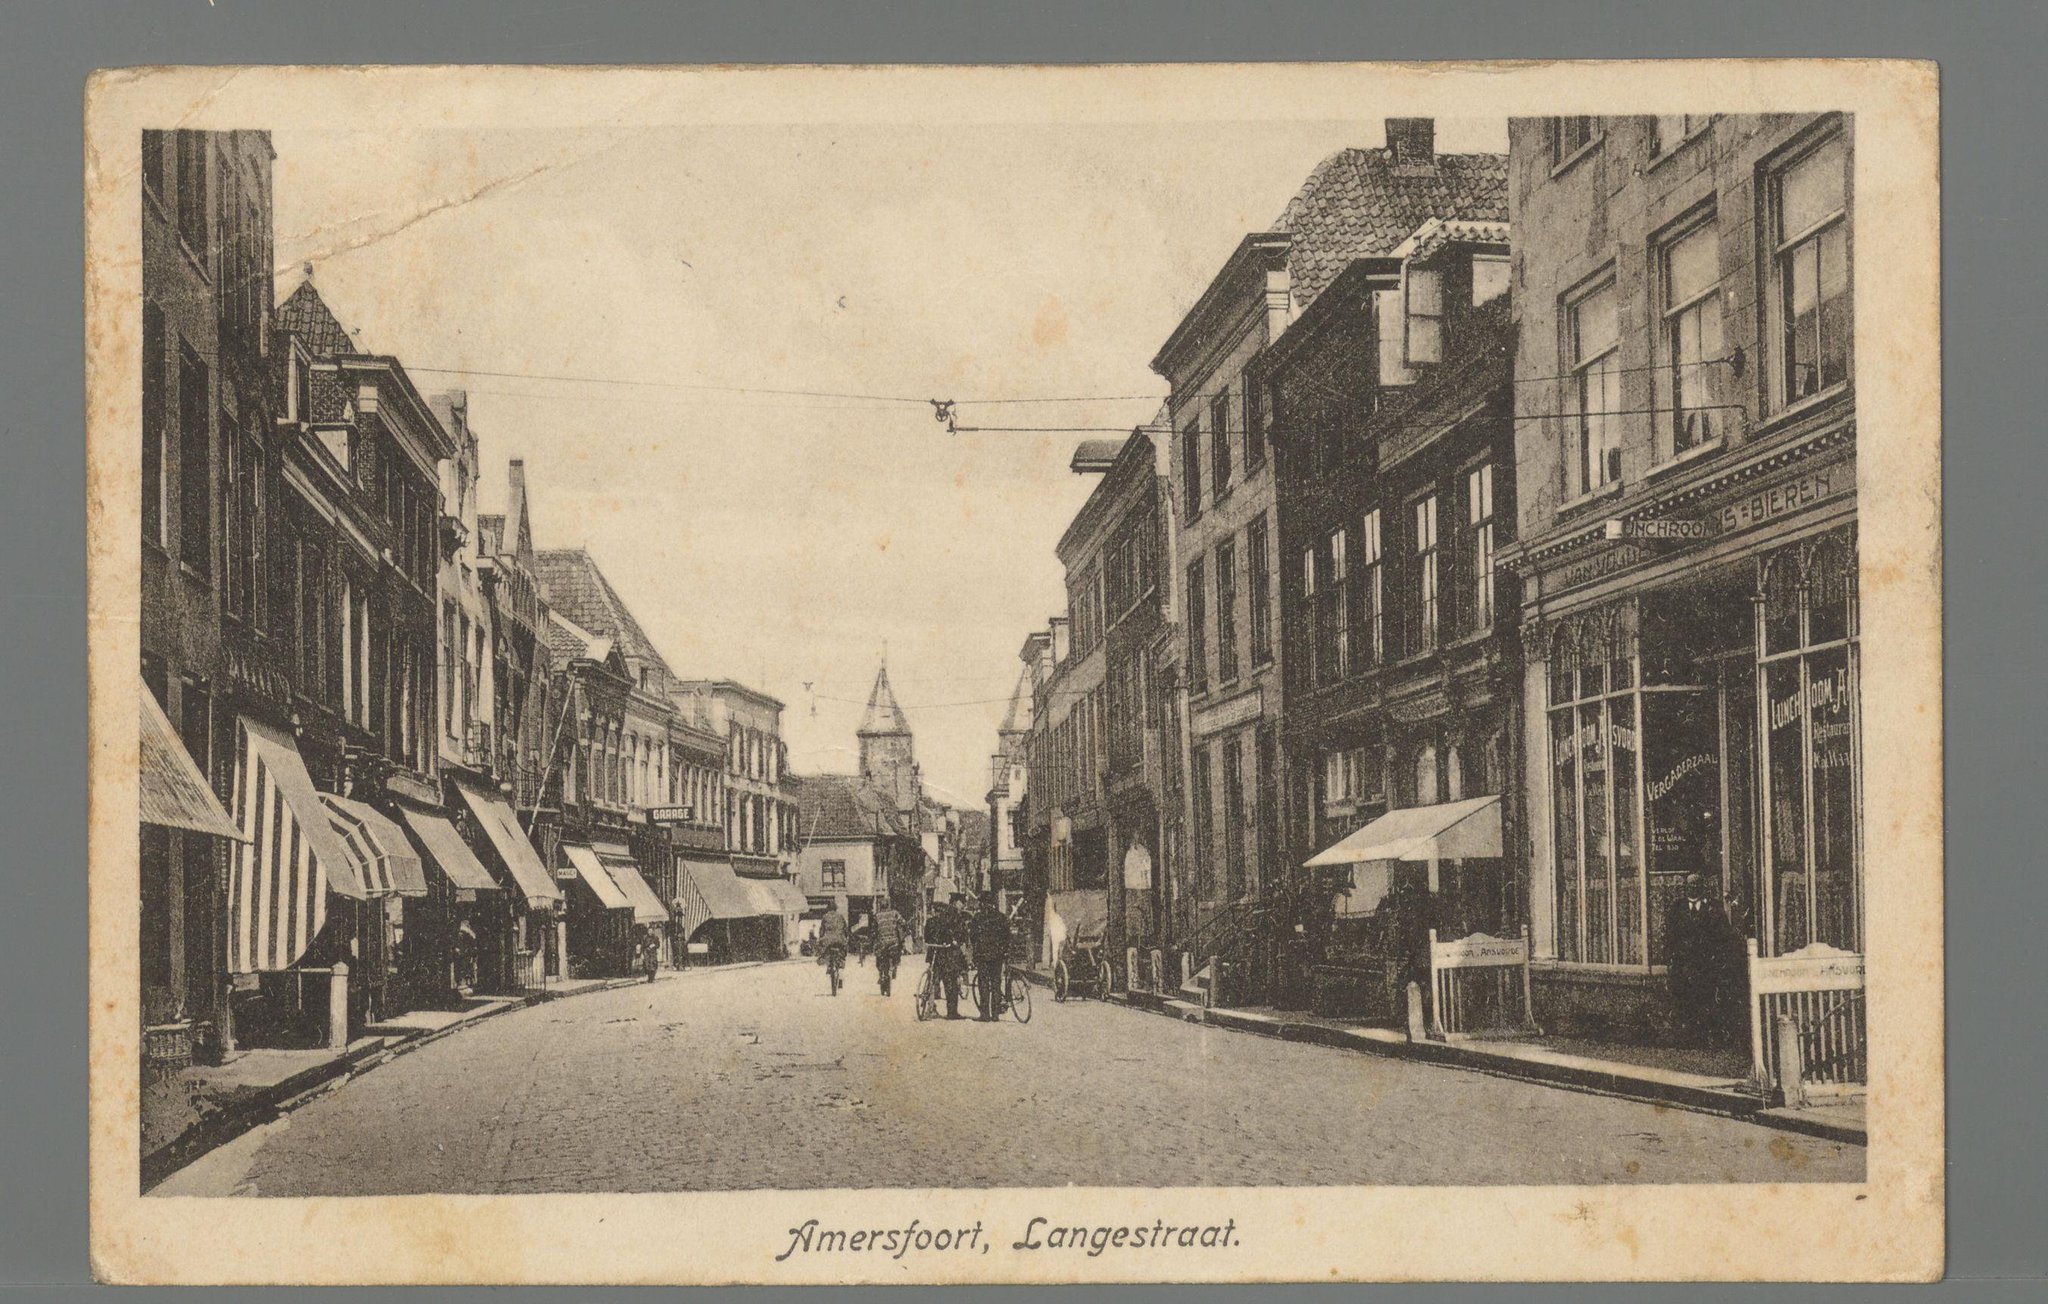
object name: photomechanical print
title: Amersfoort. Langestraat.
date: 1913-1925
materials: cardboard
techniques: photograph, writing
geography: amersfoort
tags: street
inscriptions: postage stamp